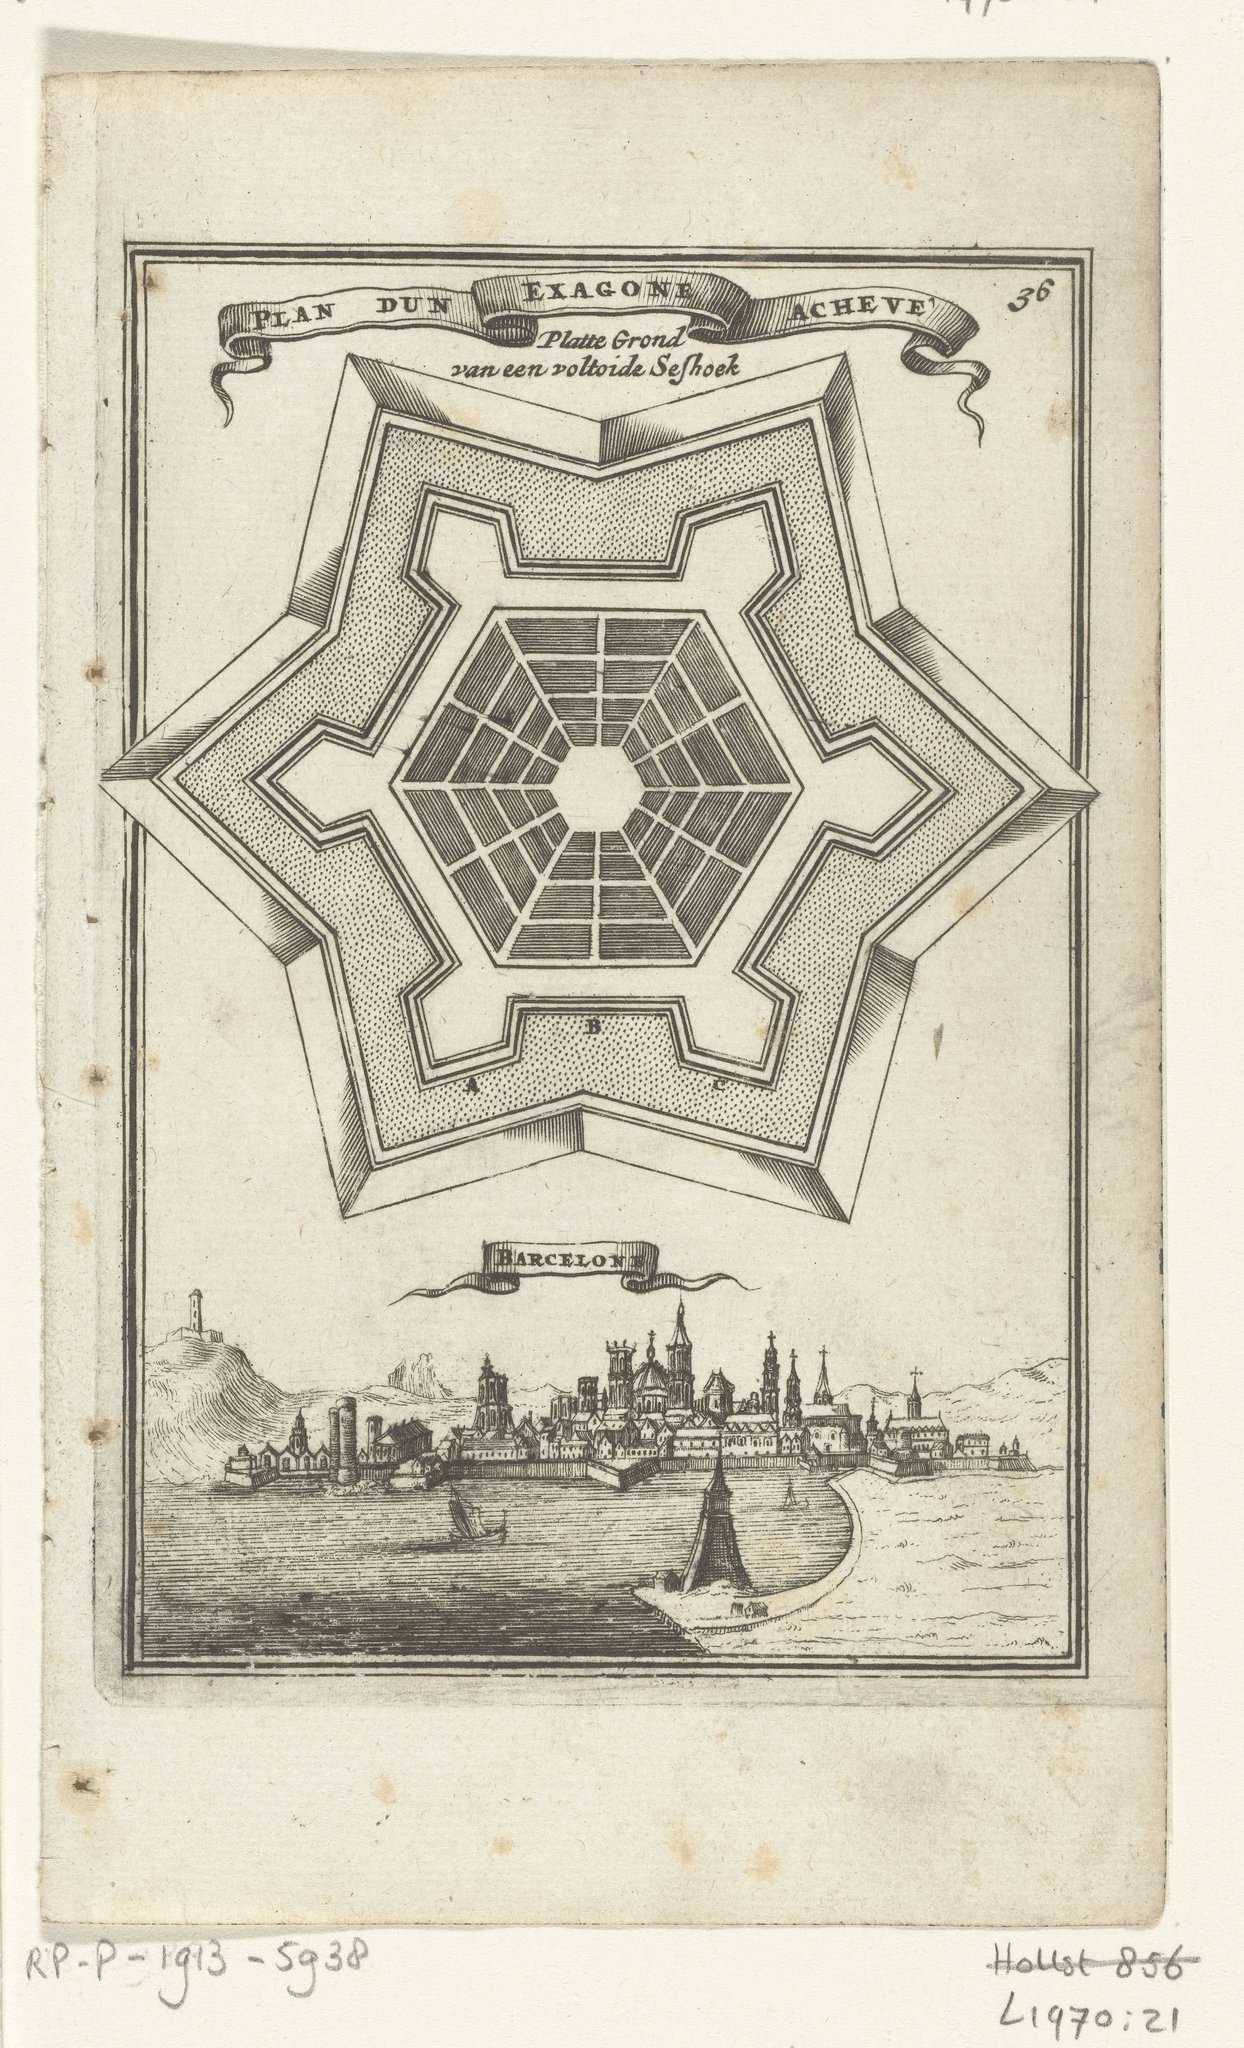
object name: print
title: Illustratie voor 'Den Arbeid van Mars' van Allain Manesson Mallet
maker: romeyn de hooghe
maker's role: draughtsman, goldsmith, painter, print maker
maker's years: 1645-1708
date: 1672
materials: paper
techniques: etching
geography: amsterdam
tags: landscapes with waters, waterscapes, seascapes (in the temperate zone), fortifications, military engineering, prospect of city, town panorama, silhouette of city, mathematics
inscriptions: collector's mark: Lugt 2228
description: Grondplan voor een vesting, fort of versterking (zeshoek). Daaronder een gezicht op Barcelona. In de hoek rechtsboven het cijfer 36 (= het nummer van de pagina in het boek waartegenover de illustratie geplaatst is).